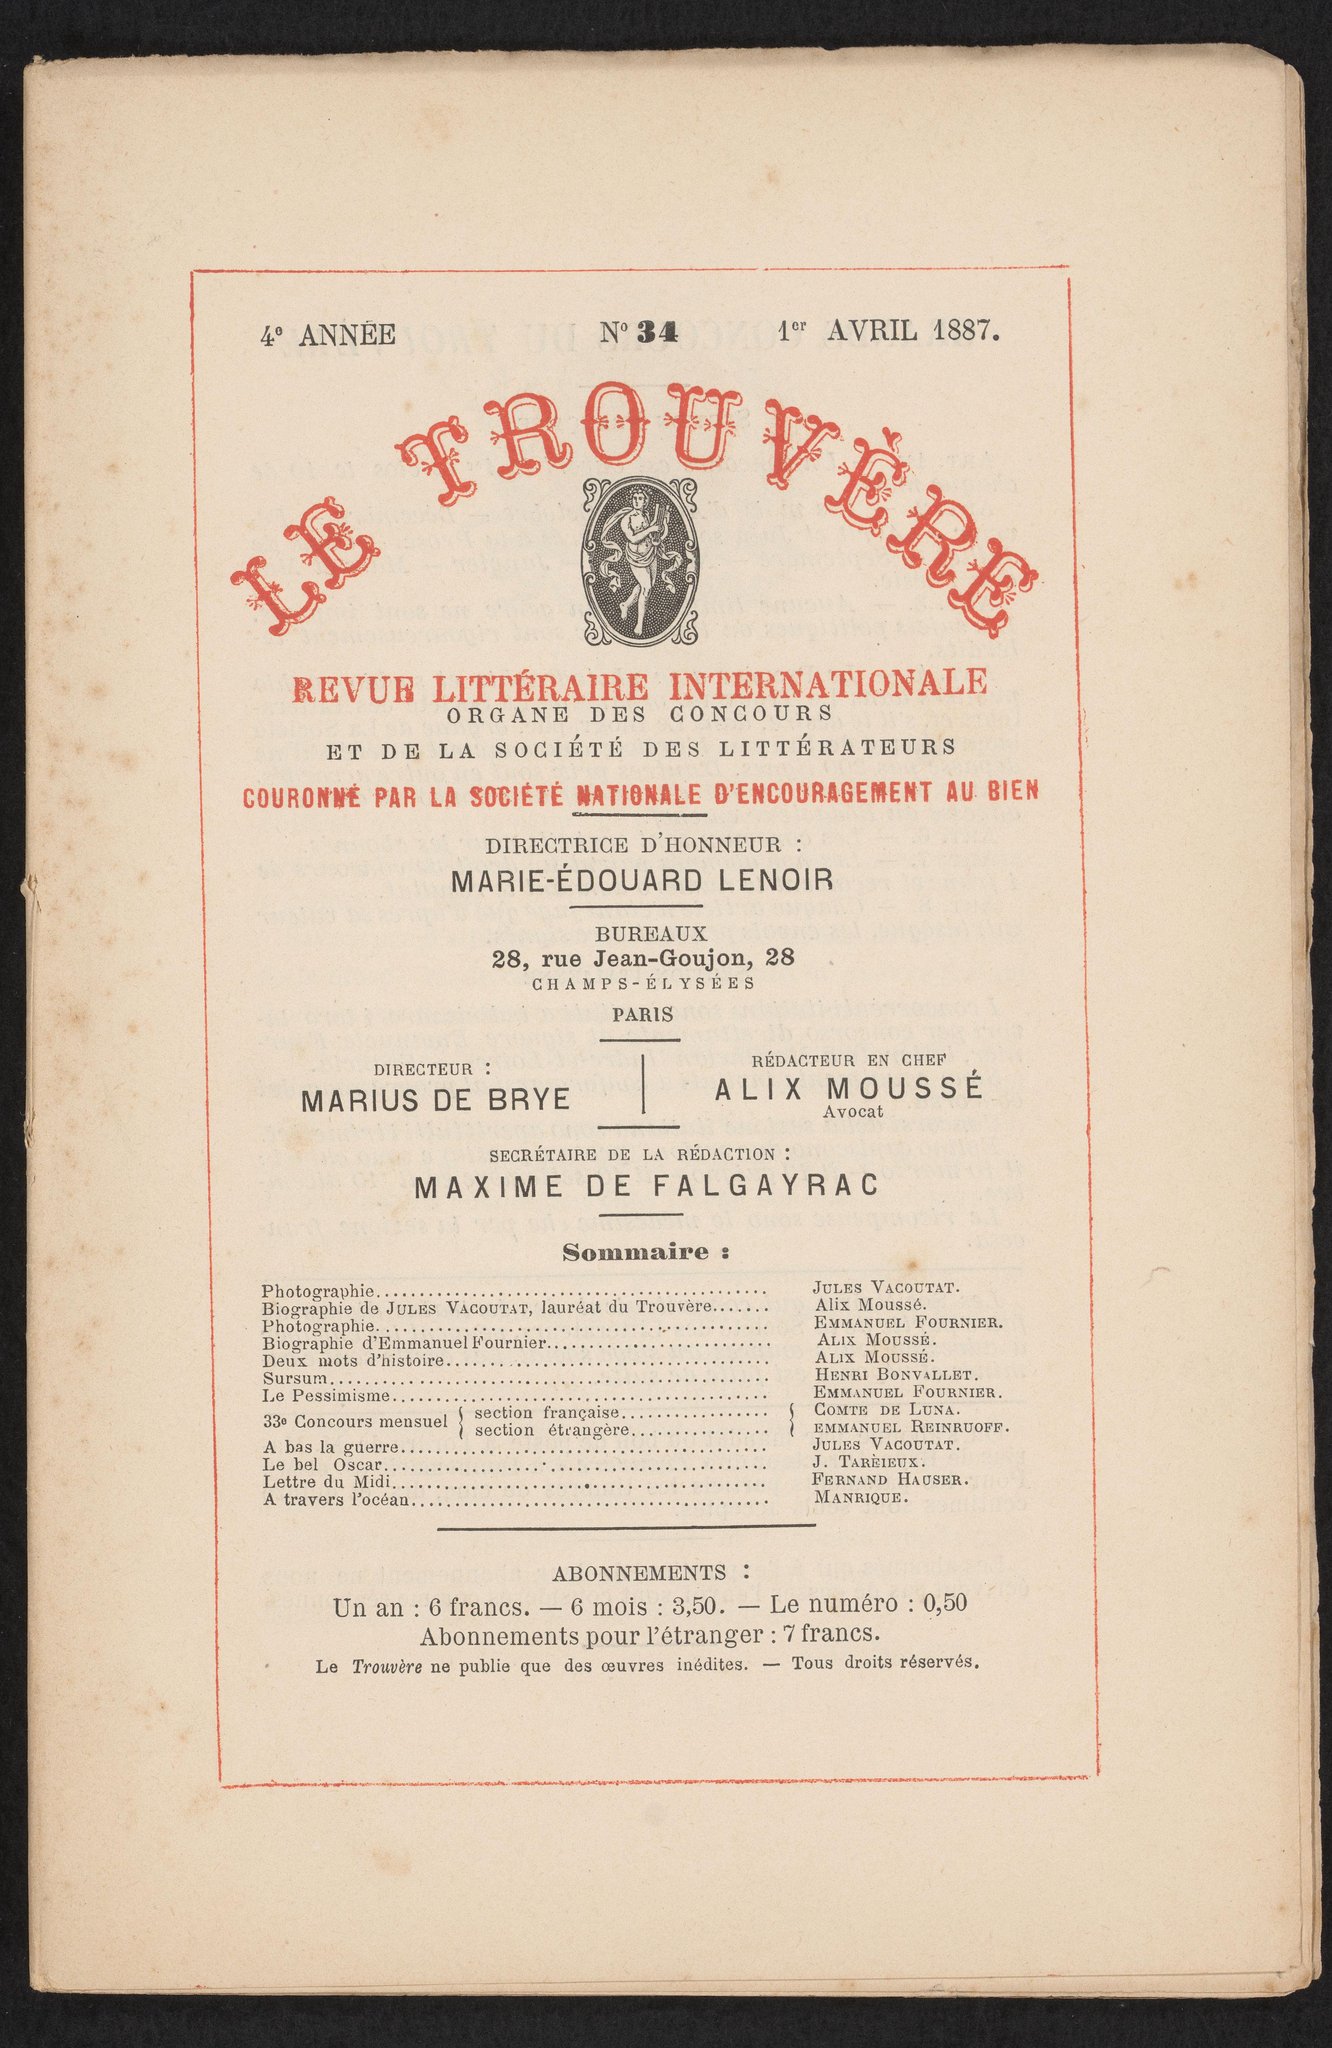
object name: book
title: Le trouvère No 34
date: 1804-1887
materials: paper, photographic support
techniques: albumen print, printing, engraving